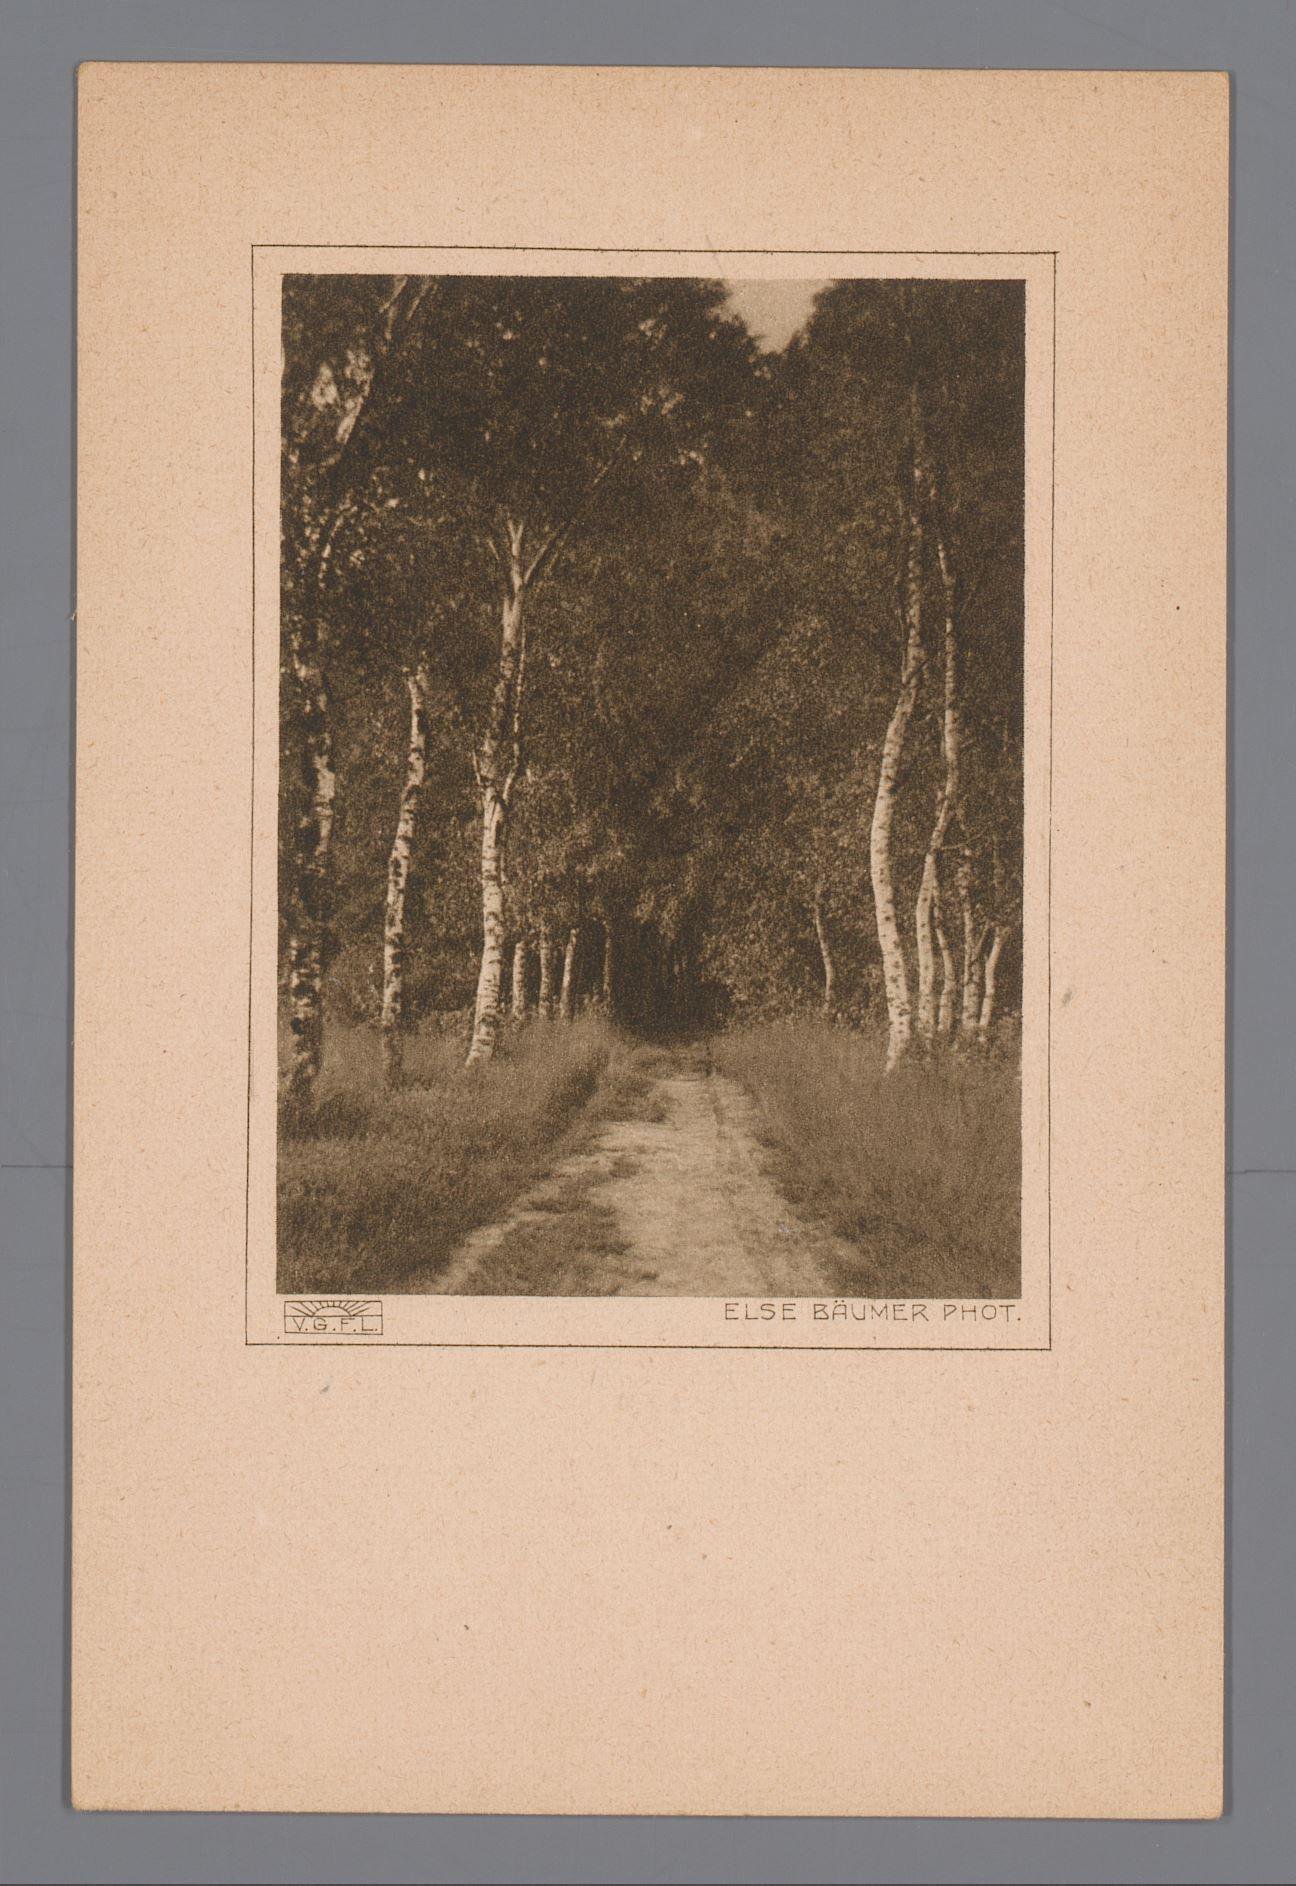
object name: rotatiedruk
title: Verlaten weg met berken aan weerzijden, Duitsland [?]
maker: else bäumer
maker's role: fotograaf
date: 1913-1940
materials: cardboard, paper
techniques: rotogravure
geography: magdeburg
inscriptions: caption: ‘V.G.F.L.’, caption: ‘Else Bäumer phot.’